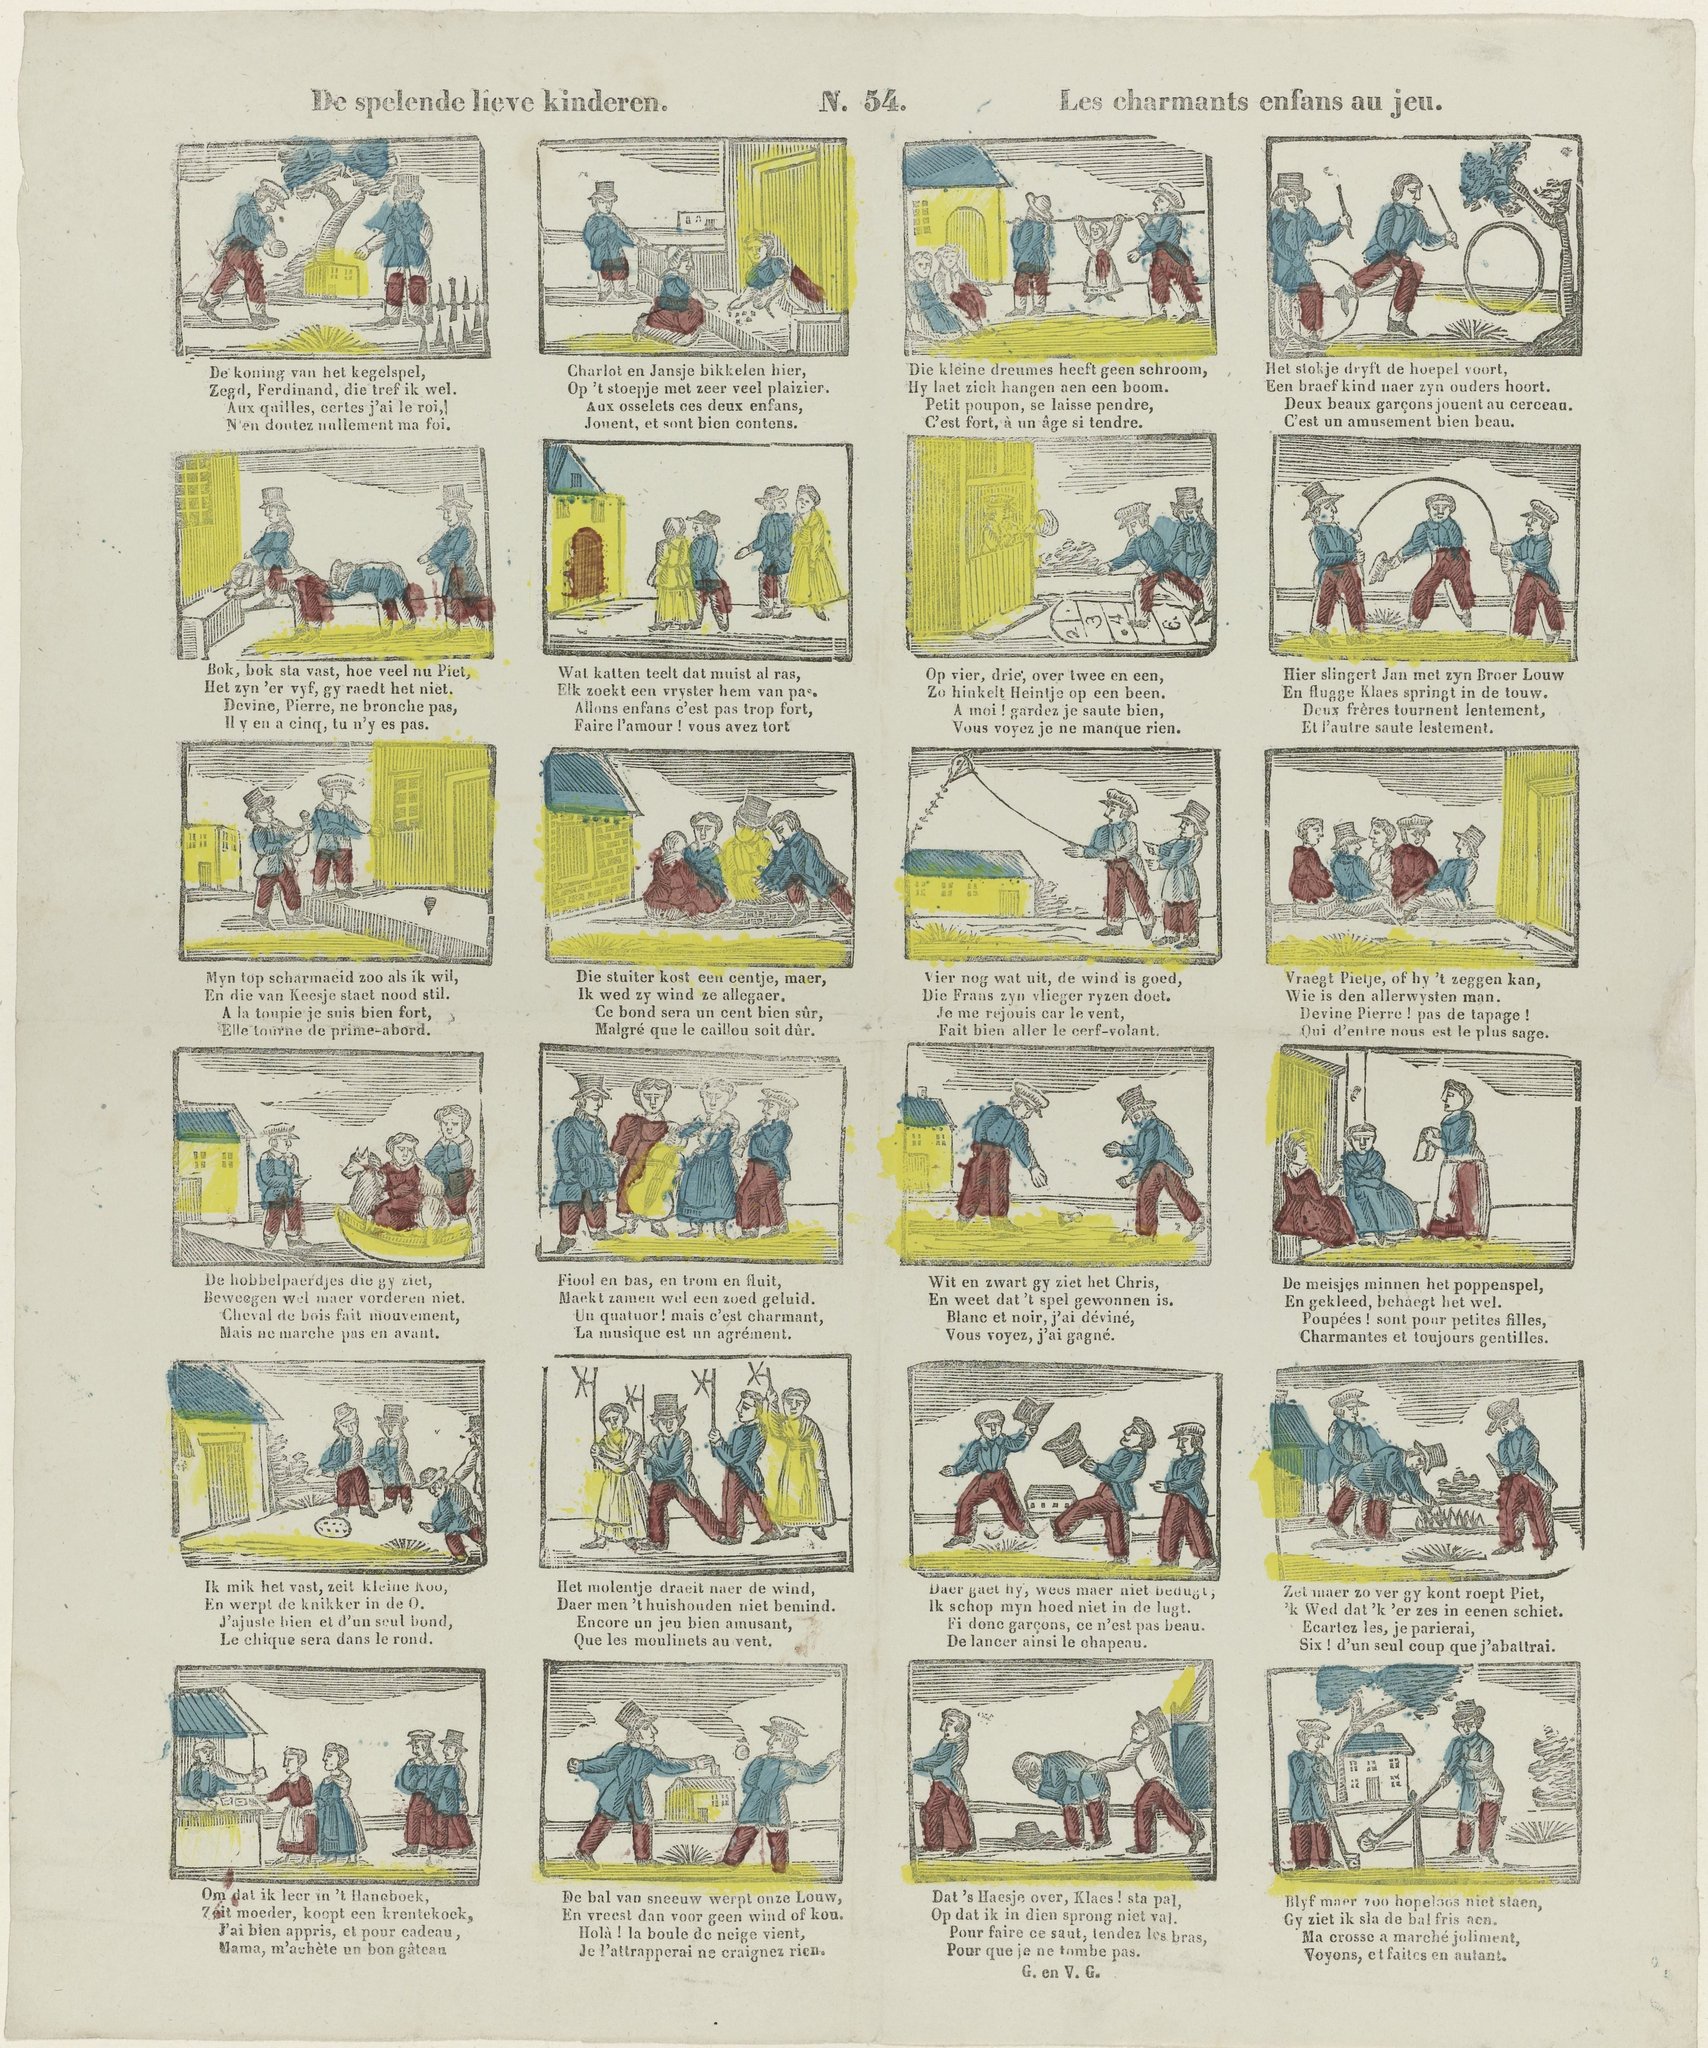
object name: print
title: De spelende lieve kinderen / Les charmant enfans au jeu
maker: Anonymous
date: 1833-1856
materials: paper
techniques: colour, letterpress printing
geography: turnhout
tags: children's games and plays, bowling games (children's games), (flying a) kite, games using special objects (marbles, top, hoop, etc.)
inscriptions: collector's mark: Lugt 2760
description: Blad met 24 voorstellingen van kinderspelen, zoals kegelen, hoepelen, vliegeren en knikkeren. Onder elke afbeelding een tweeregelig vers in het Nederlands en in het Frans. Genummerd midden boven: N. 54.